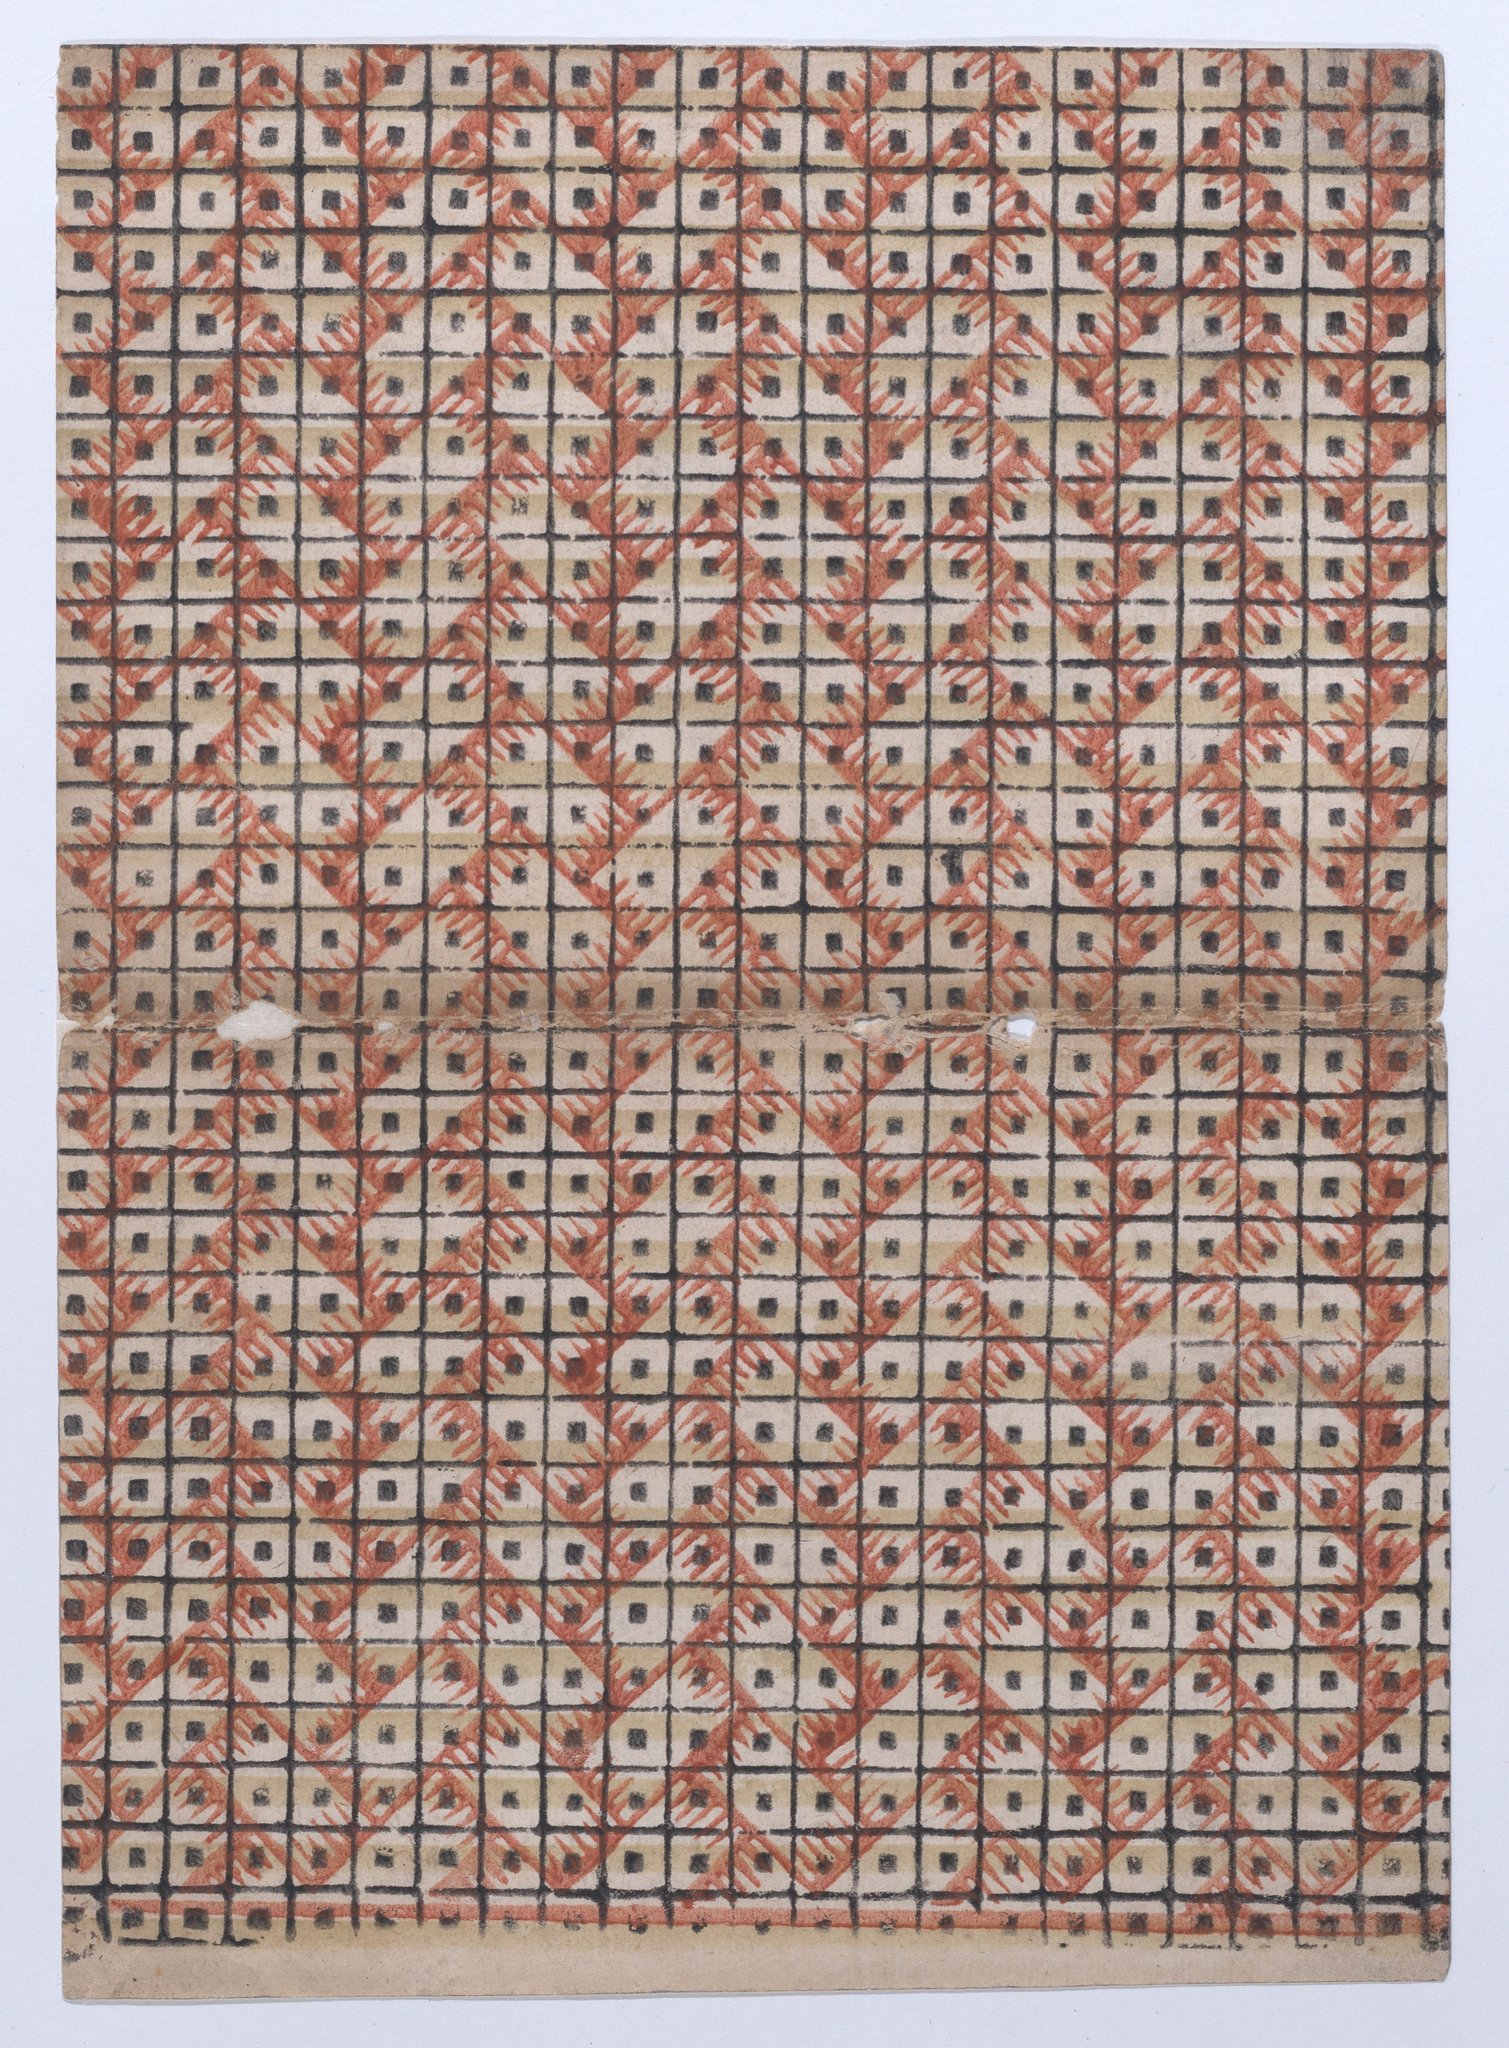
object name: print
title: Book cover with overall grid pattern with geometric designs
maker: Anonymous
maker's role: artist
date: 1801-1900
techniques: relief print